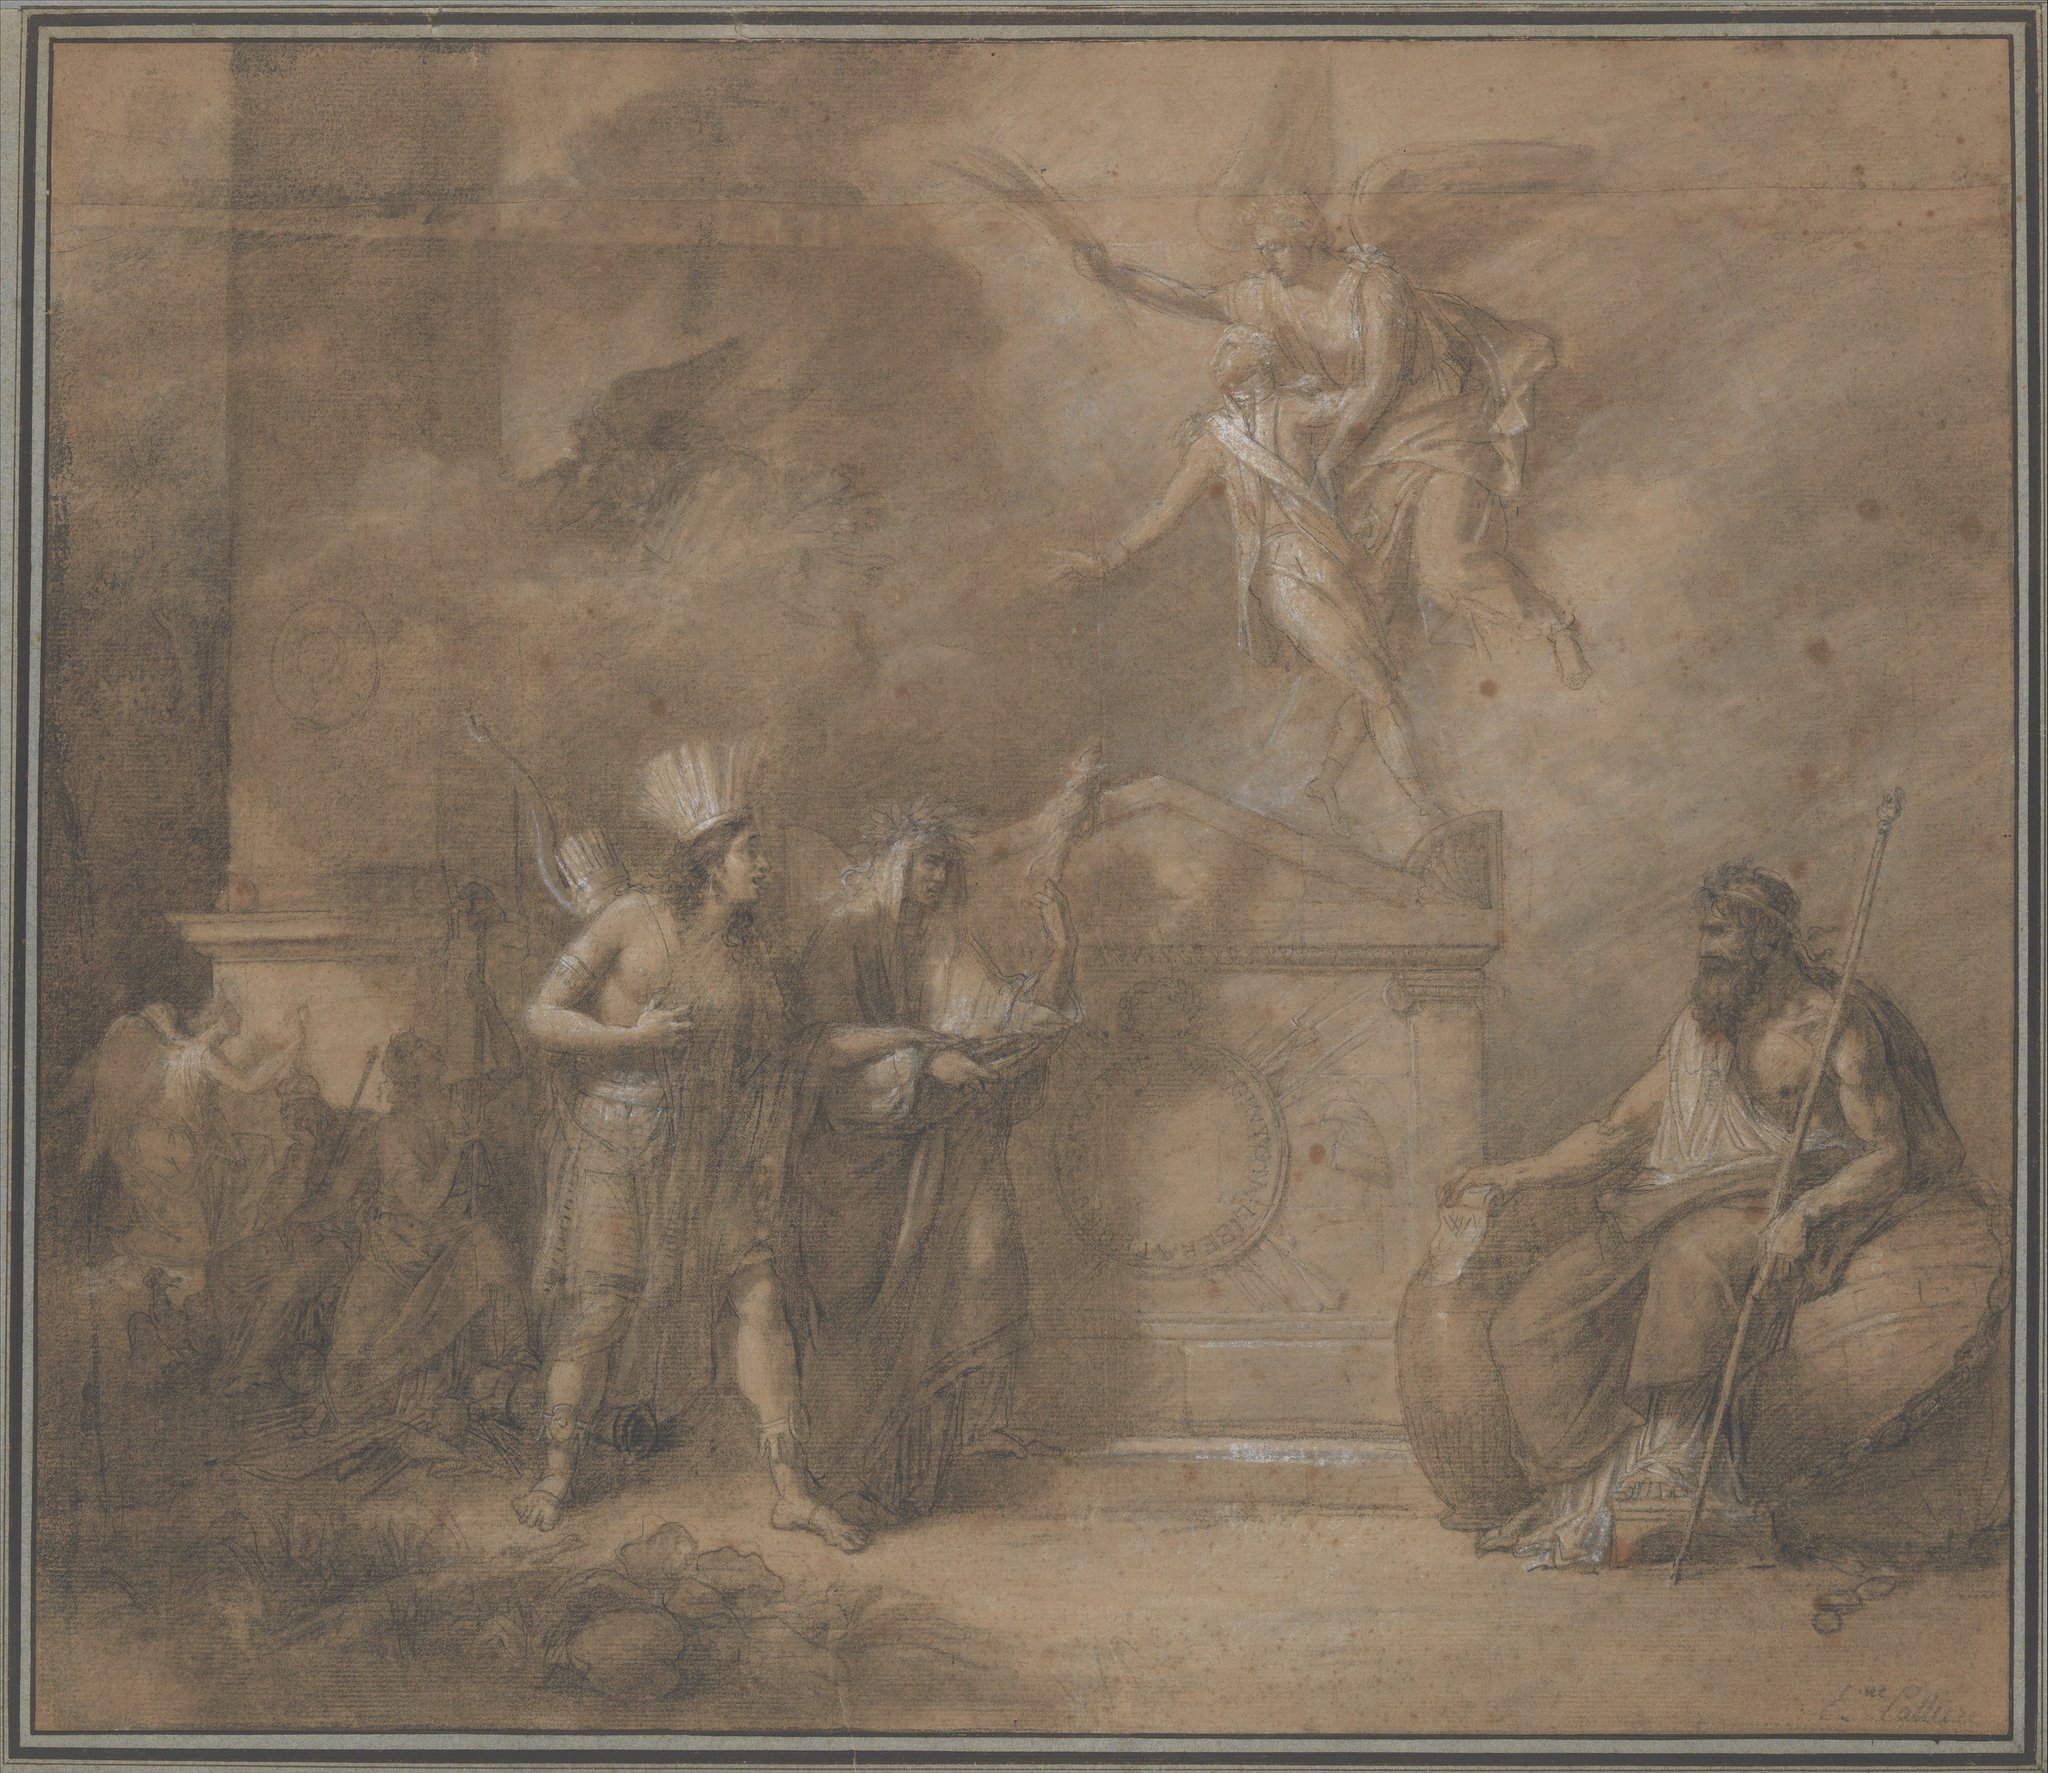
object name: drawing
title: Washington's Tomb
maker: etienne pallière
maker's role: artist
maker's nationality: french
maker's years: 1761-1820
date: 1799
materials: chalk, crayon, paper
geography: france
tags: tombs,bow and arrow,men,women